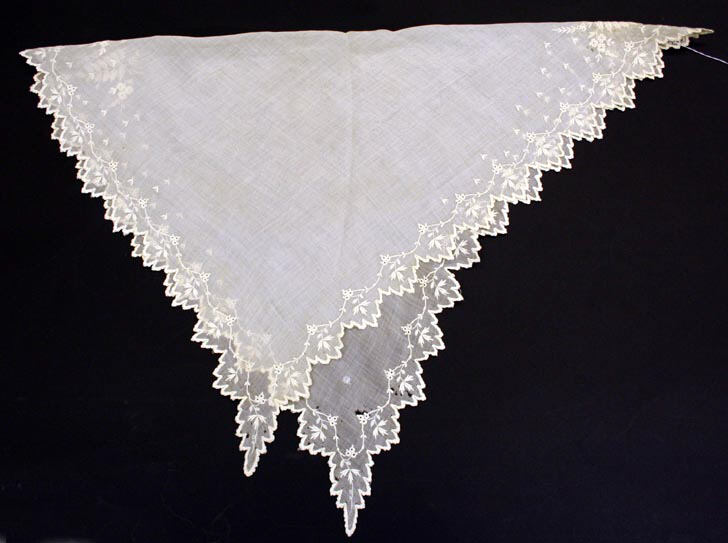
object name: kerchief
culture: american or european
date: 1701-1800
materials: cotton